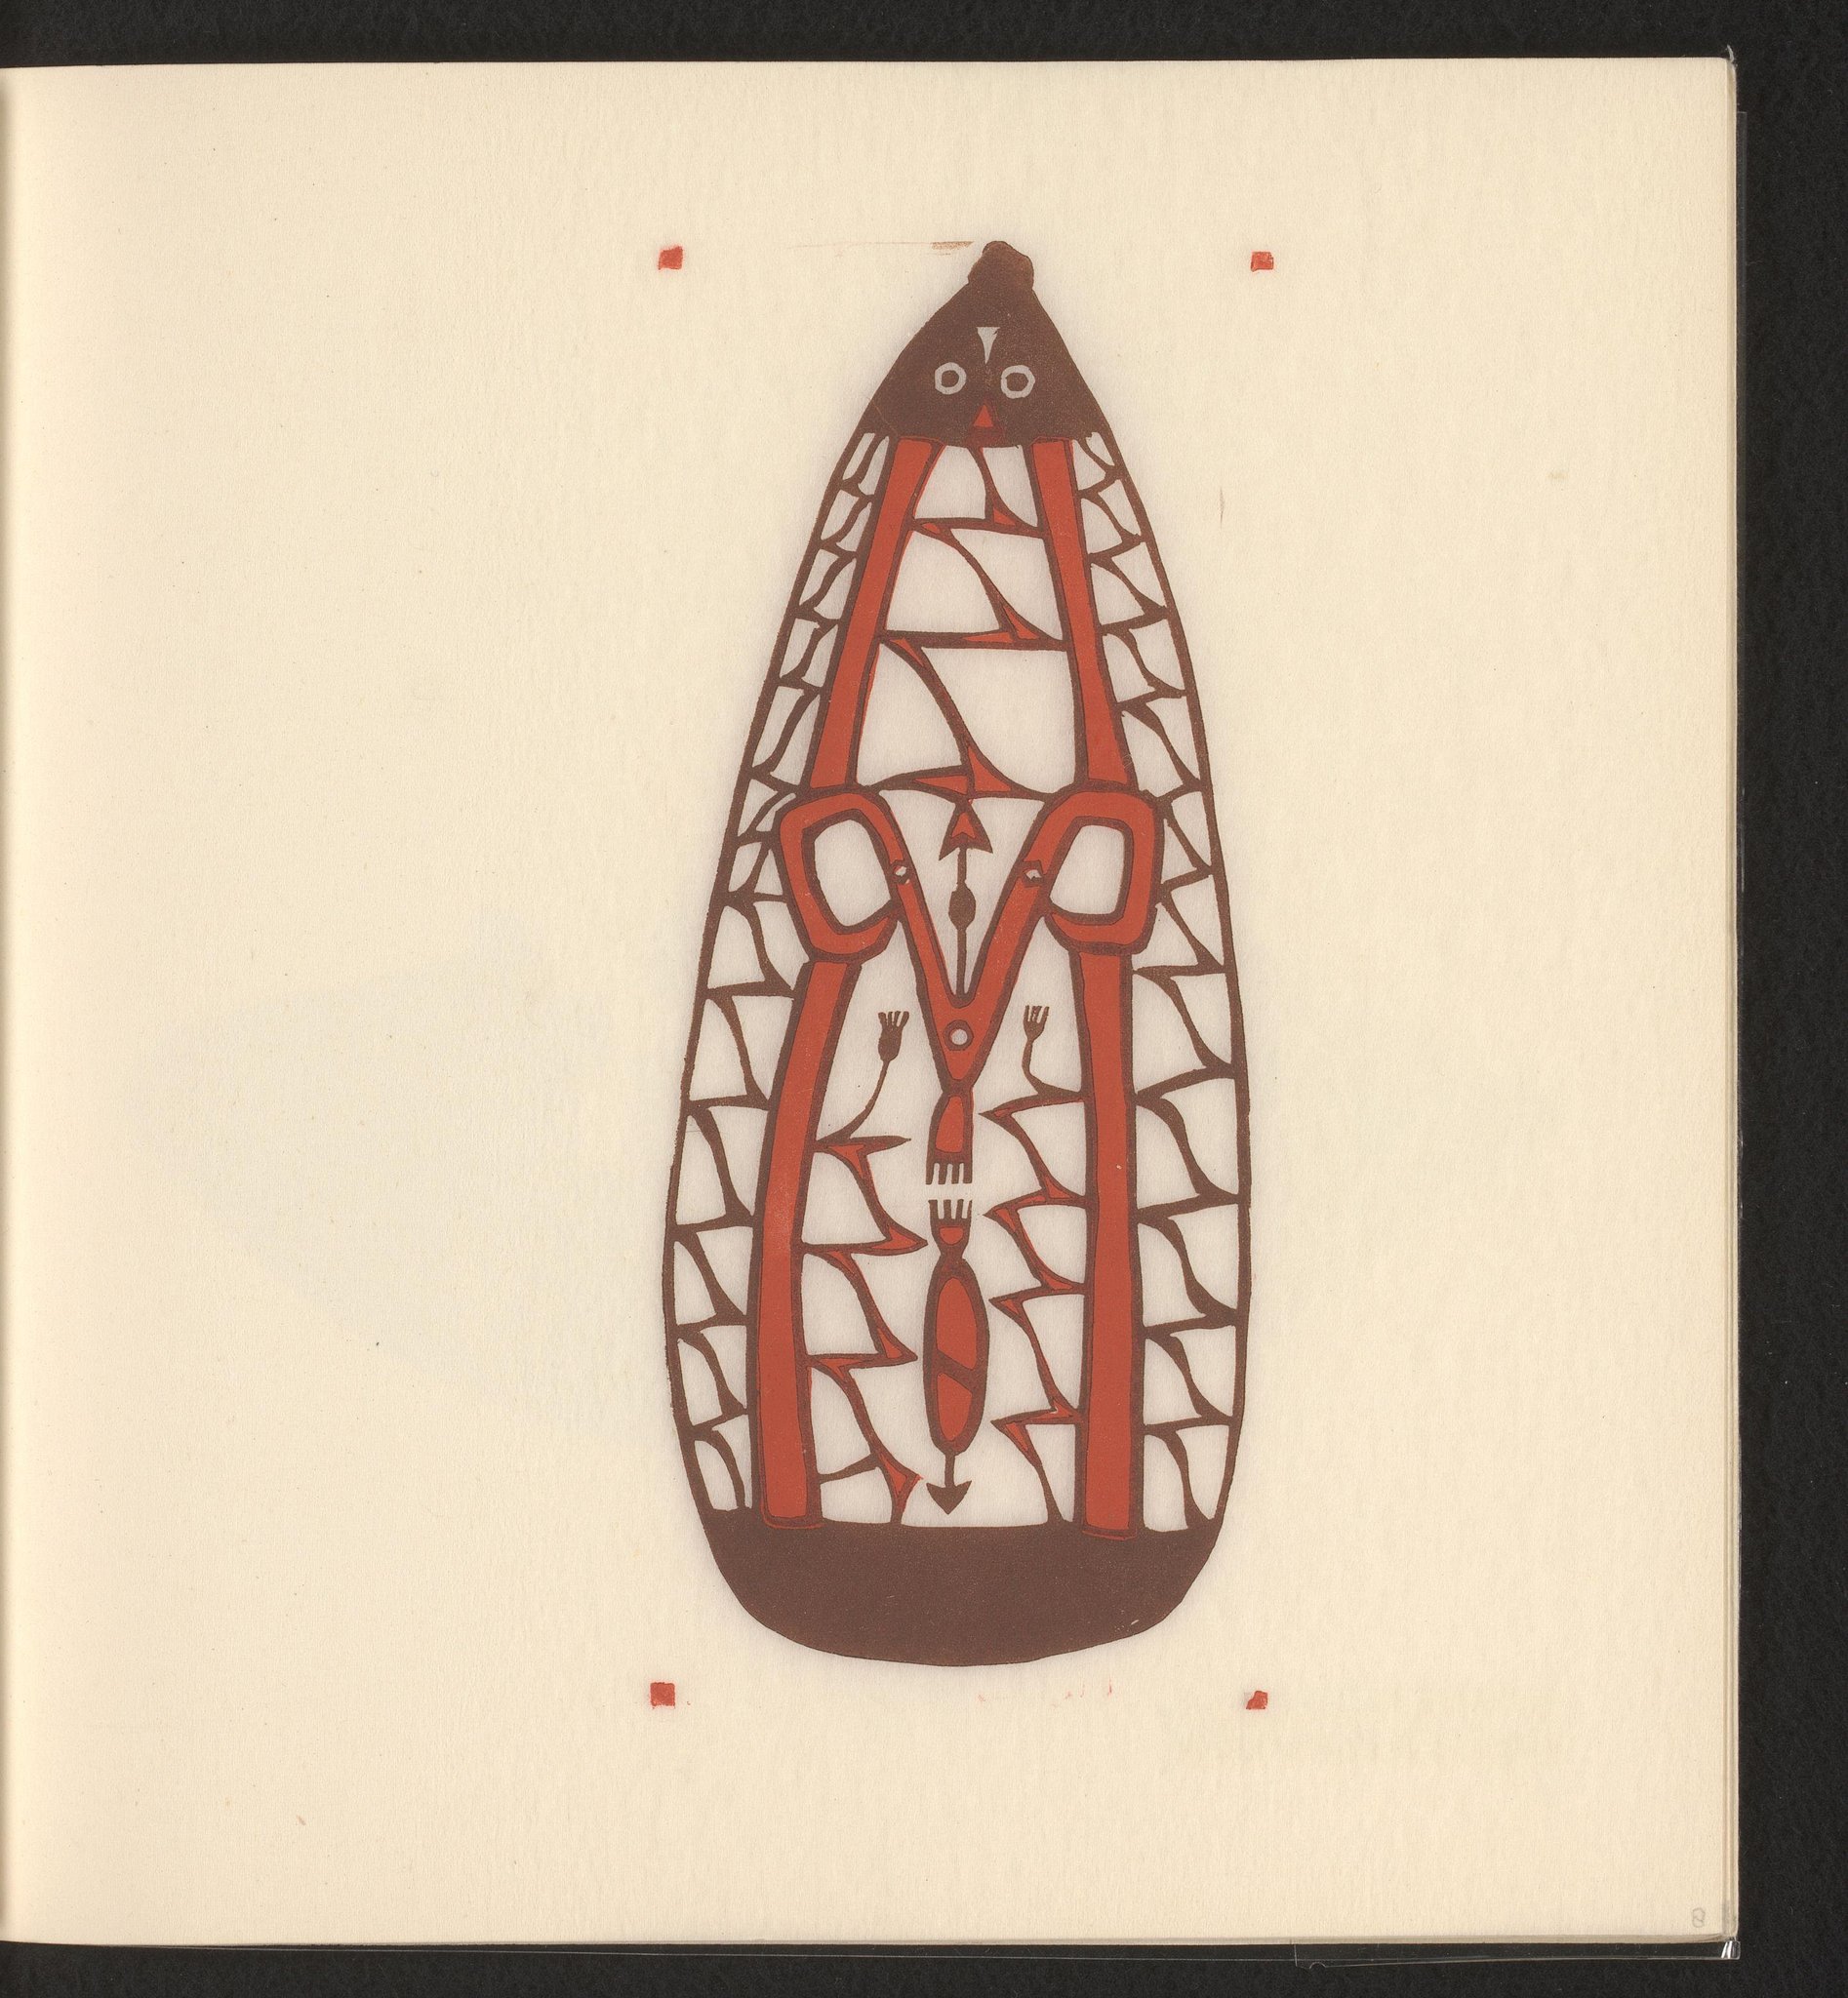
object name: print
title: Schild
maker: reijer stolk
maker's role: draughtsman, print maker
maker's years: 1896-1945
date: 1942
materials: paper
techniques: woodcut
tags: protective weapons: shield, indonesia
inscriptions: date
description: Langwerpig schild met decoratief patroon. Onderdeel van album 'Tien bladen sierkunst uit ons Oost-Indië'.